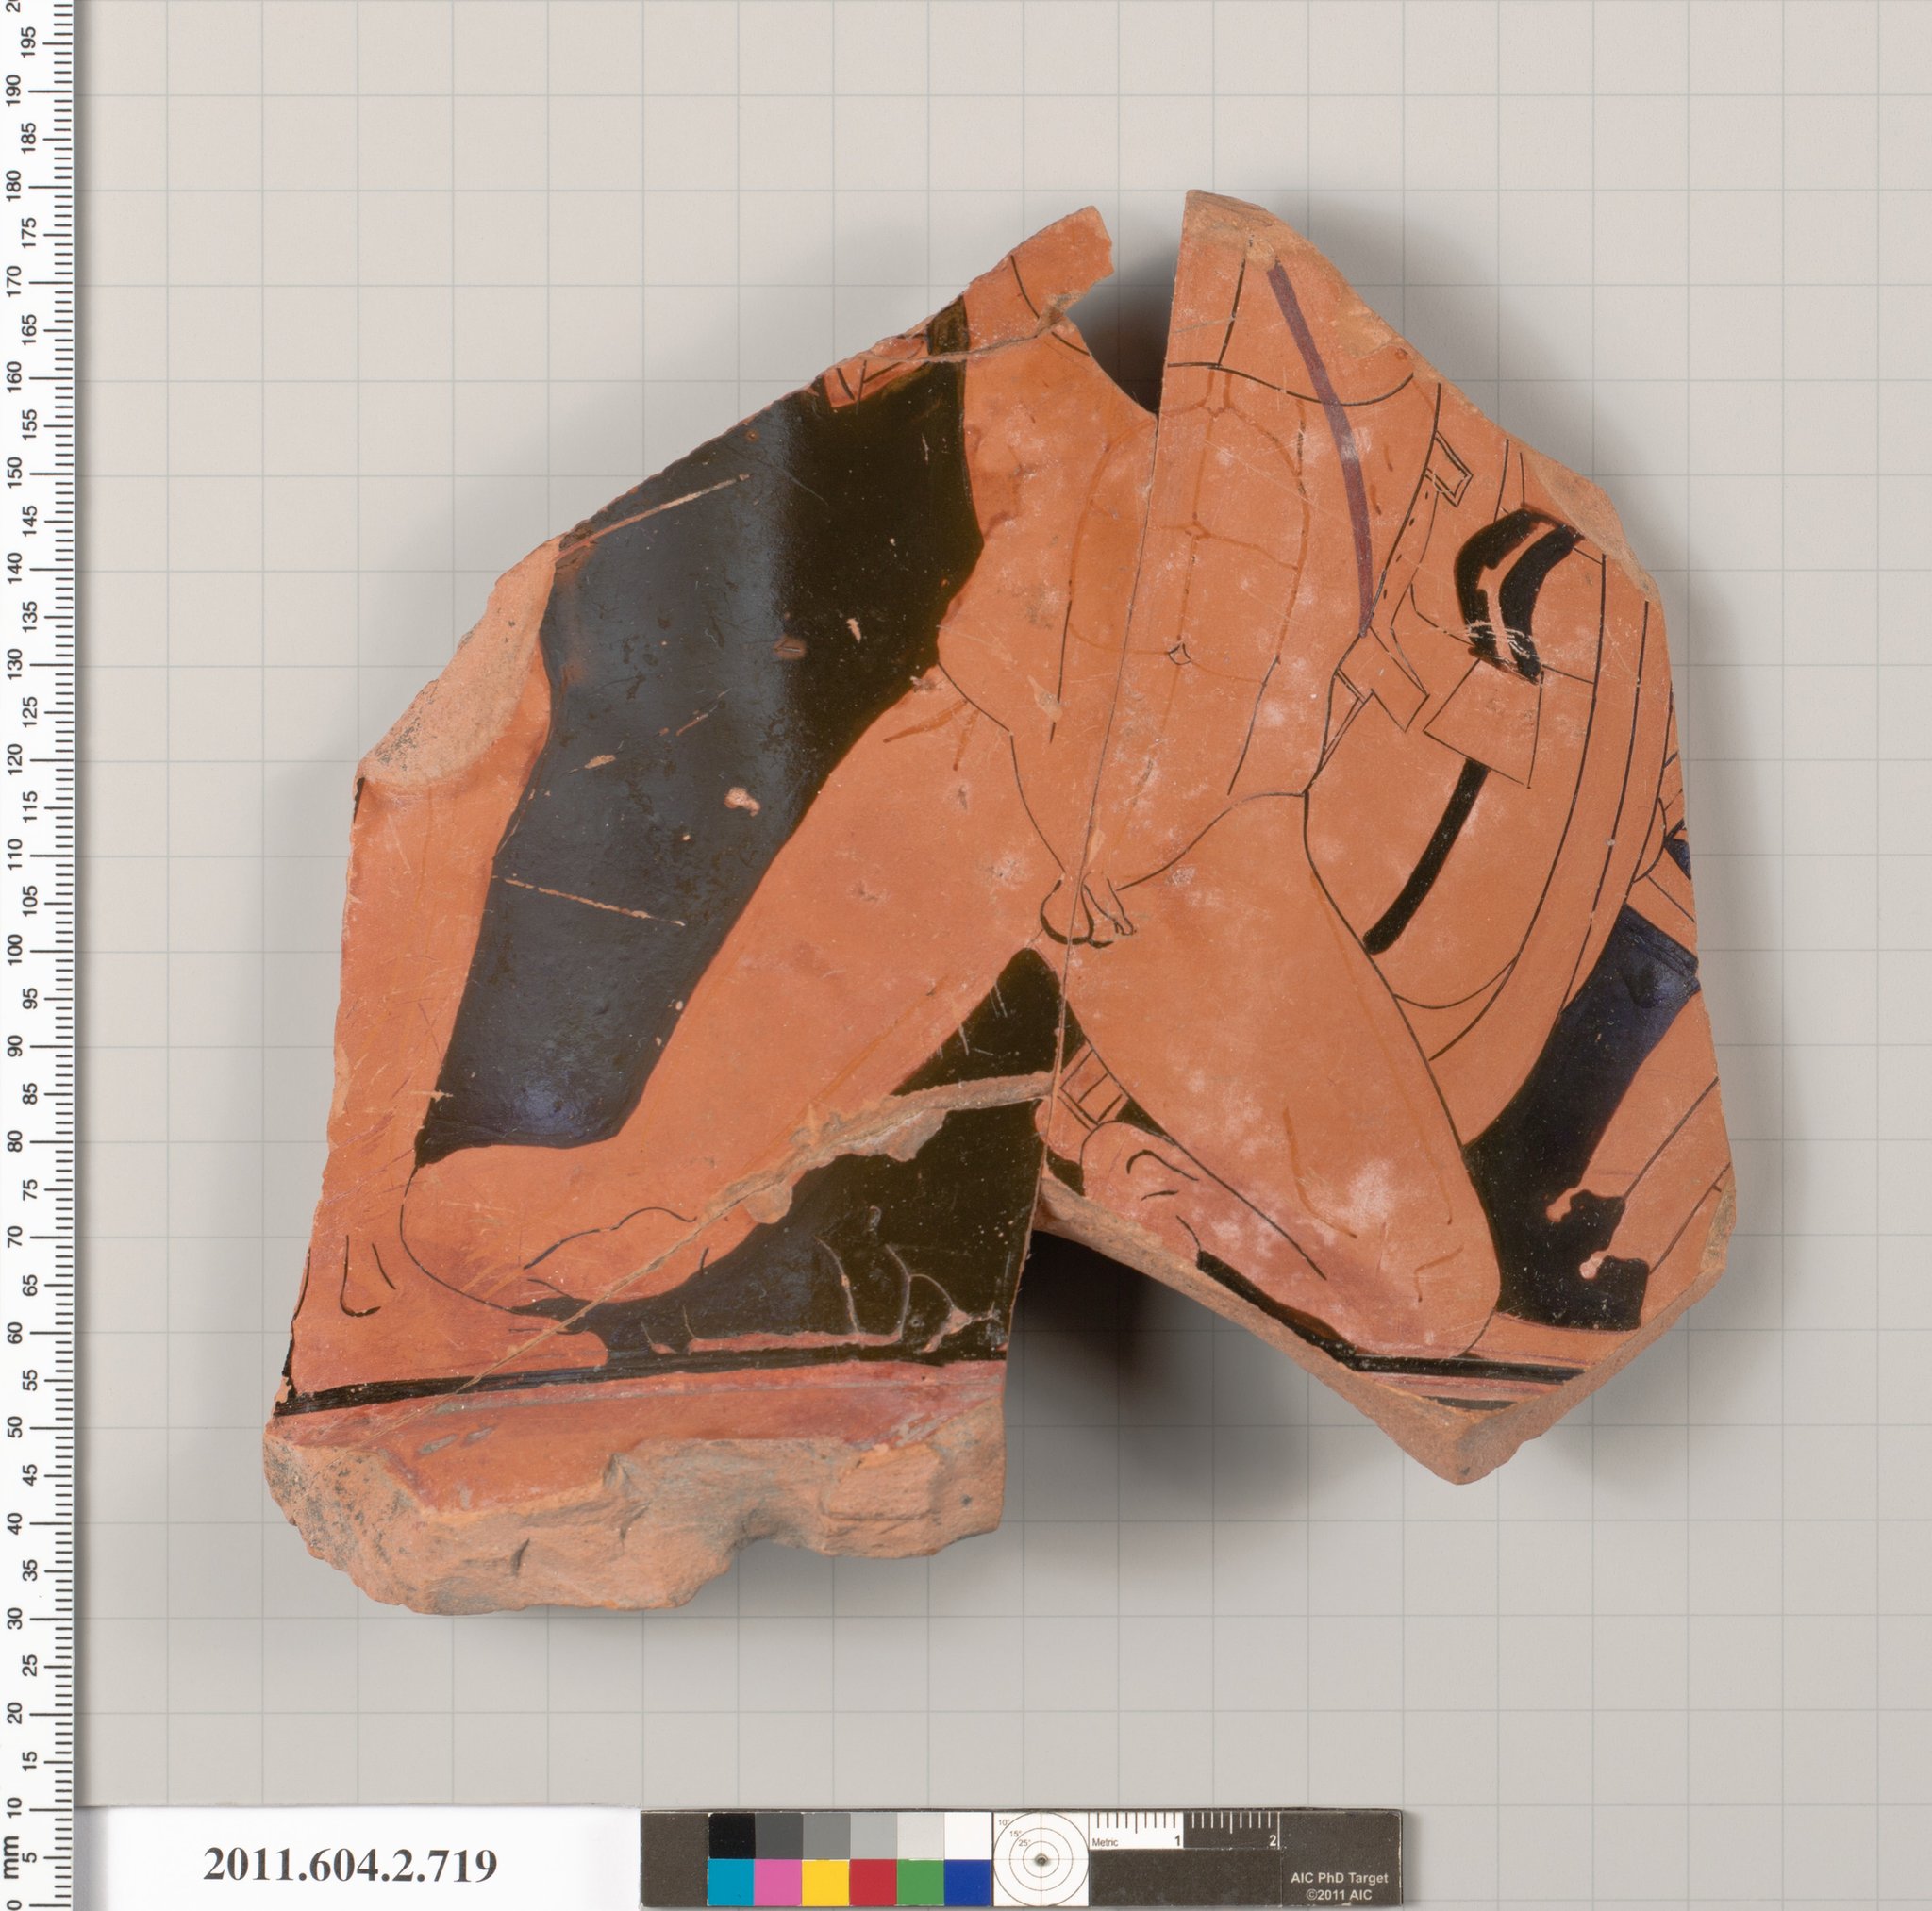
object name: calyx krater fragment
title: Terracotta fragment of a calyx-krater (bowl for mixing wine and water)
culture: greek, attic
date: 467-435 BCE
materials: terracotta